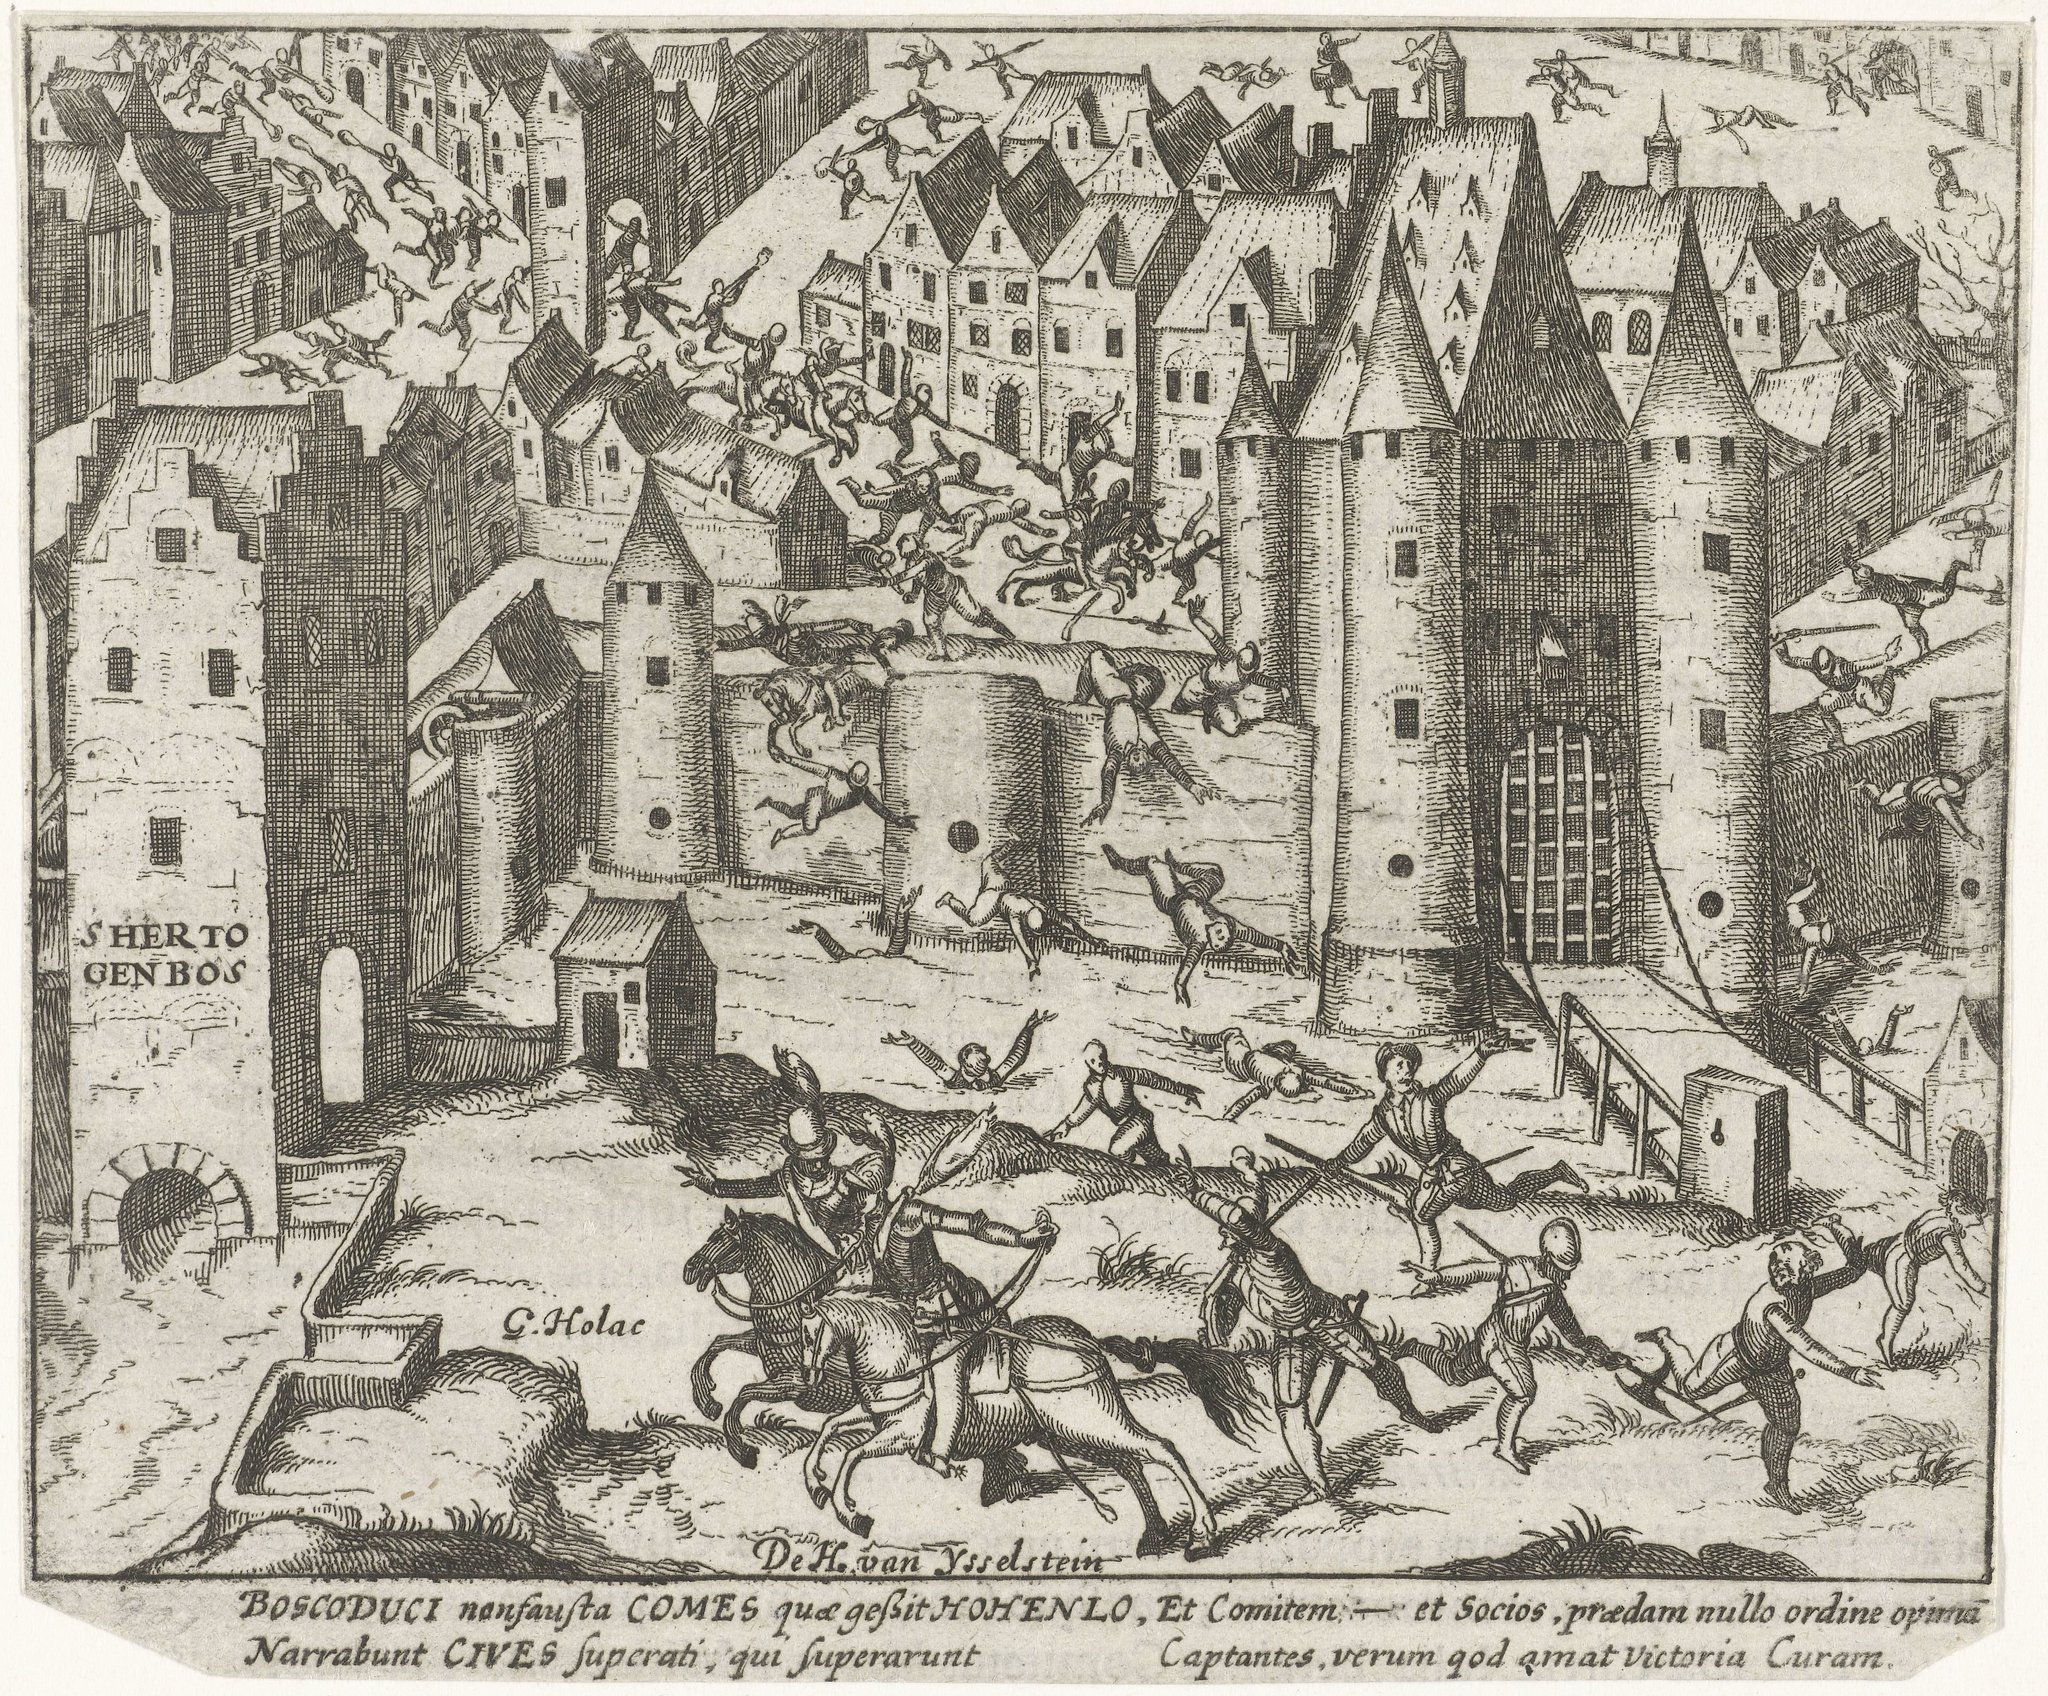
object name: print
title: Mislukte aanslag op 's-Hertogenbosch, 1585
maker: Anonymous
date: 1613-1615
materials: paper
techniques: etching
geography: northern netherlands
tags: battle, den bosch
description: Mislukte aanslag door het Staatse leger onder bevel van graaf Hohenlohe op 's-Hertogenbosch, 19 januari 1585. Op de voorgrond vlucht de graaf van Hohenlohe te paard, in de stad worden de indringers verjaagd. Met onderschrift van 4 regels in het Latijn. Bedrukt op achterzijde met tekst in het Latijn.